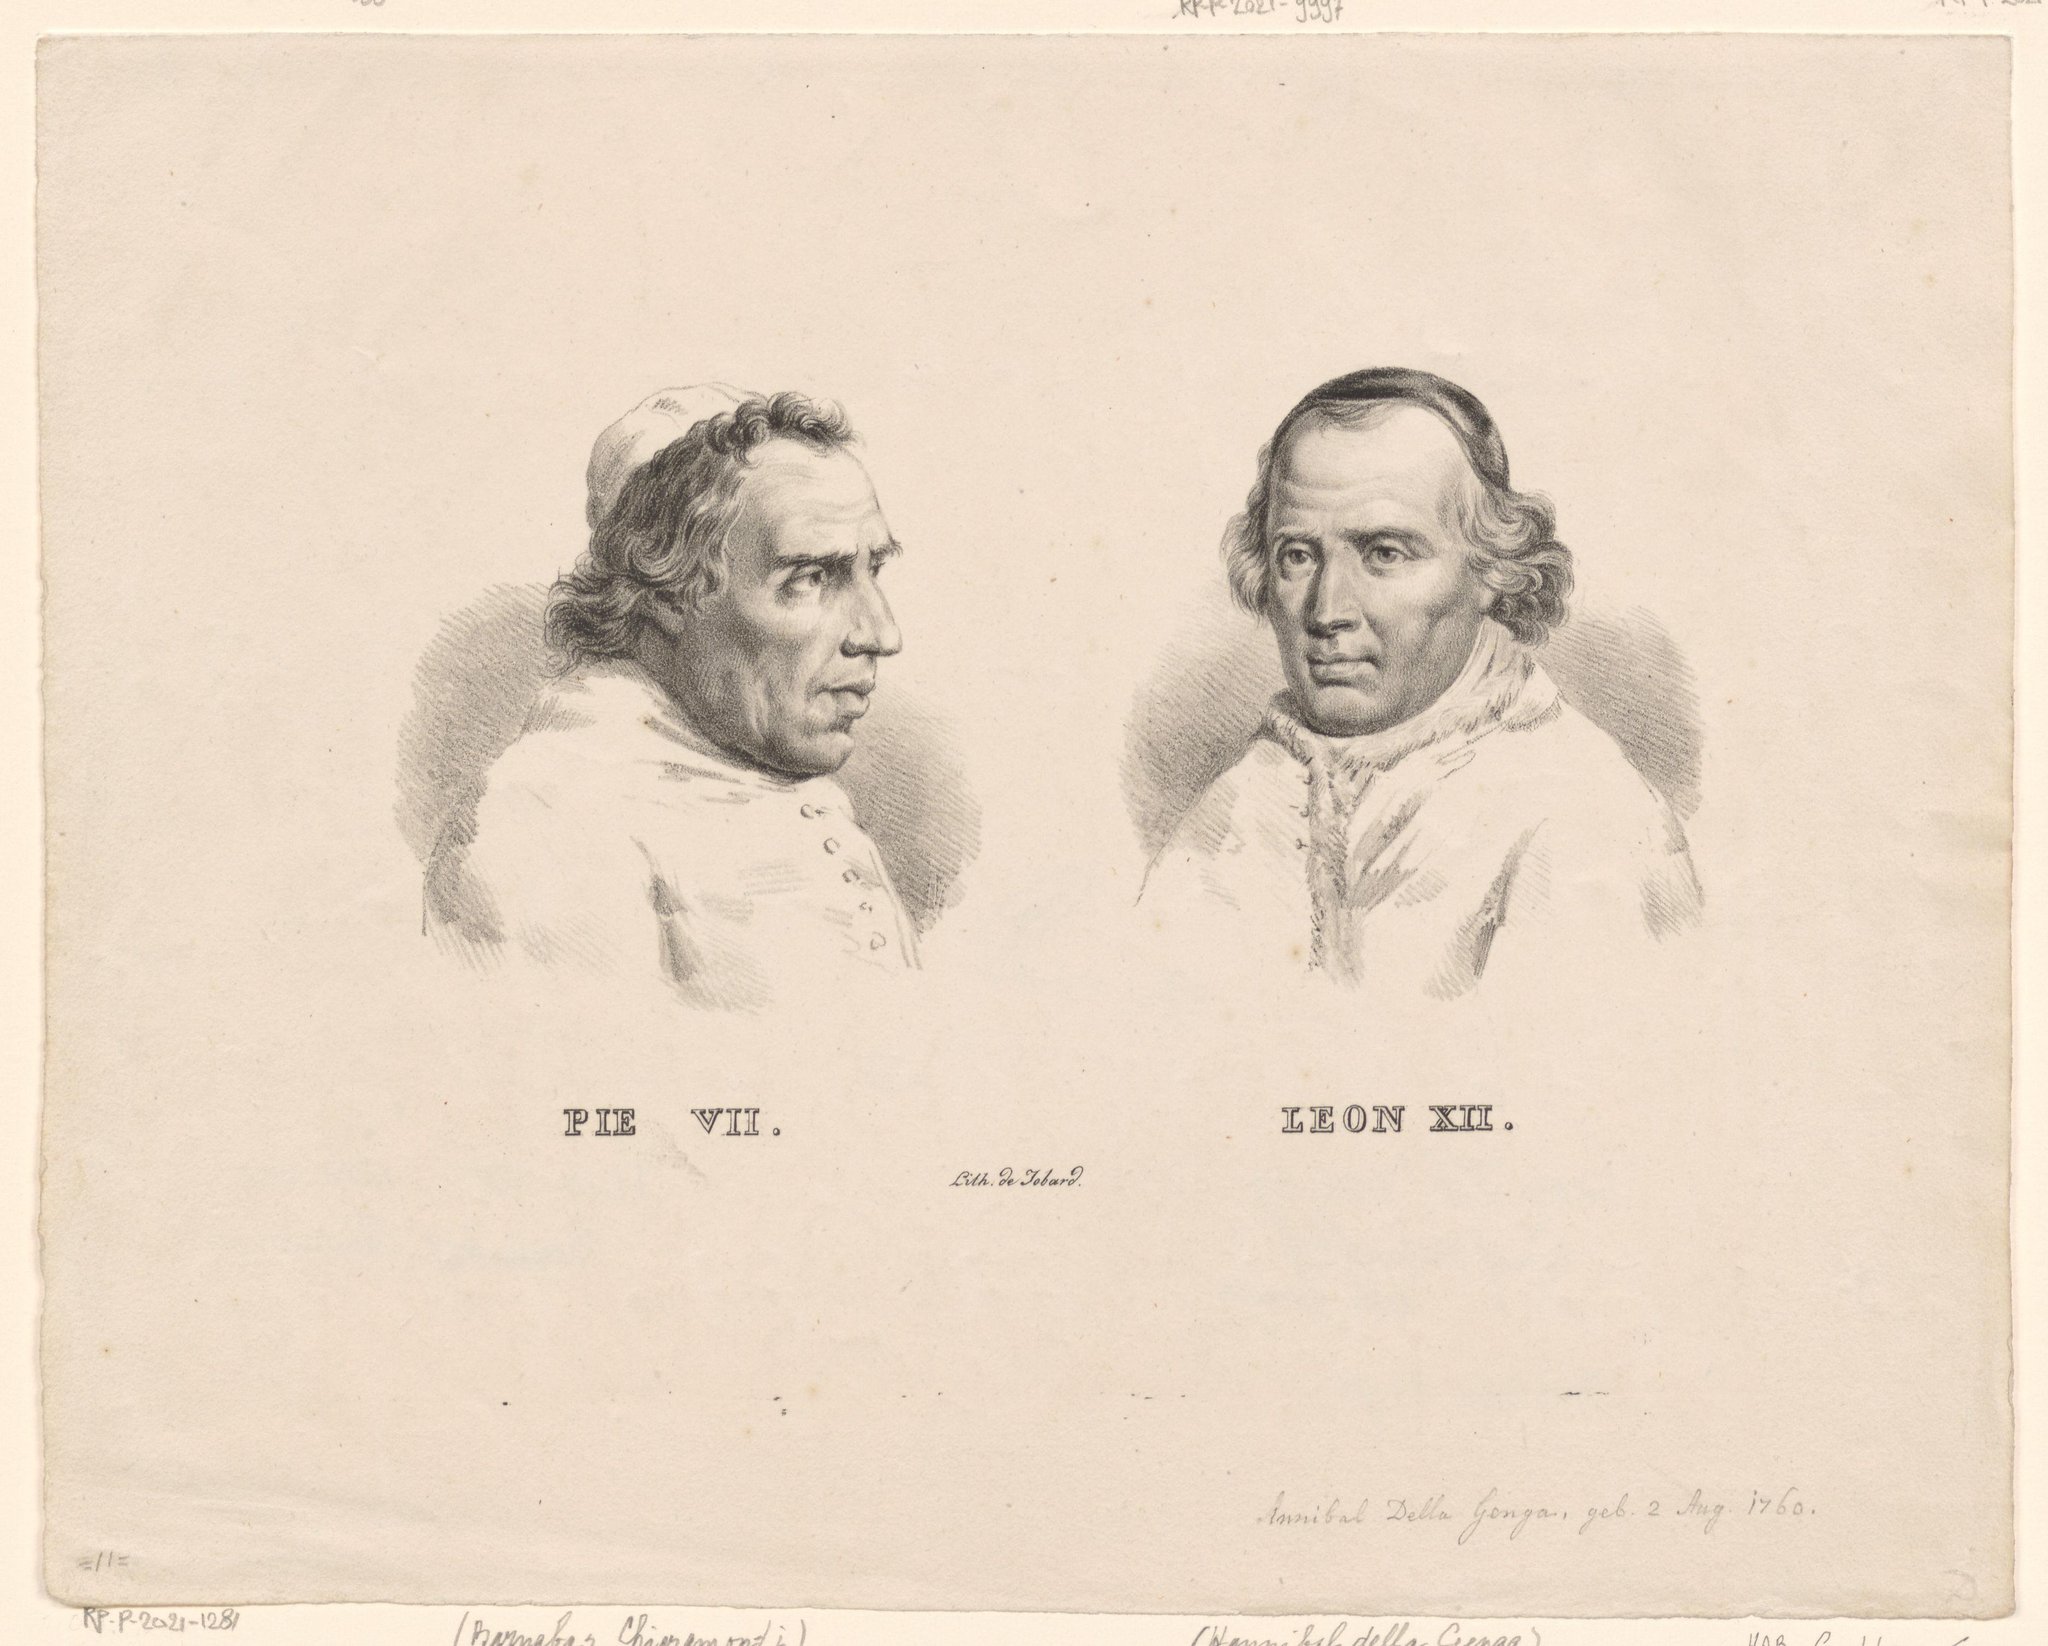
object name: print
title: Portretten van Pius VII en Leo XII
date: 1823-1861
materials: paper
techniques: lithograph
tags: rome, clergyman, pius vii, historical persons, pope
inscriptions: collector's mark: Lugt 2228, watermark: ‘Hulpe’